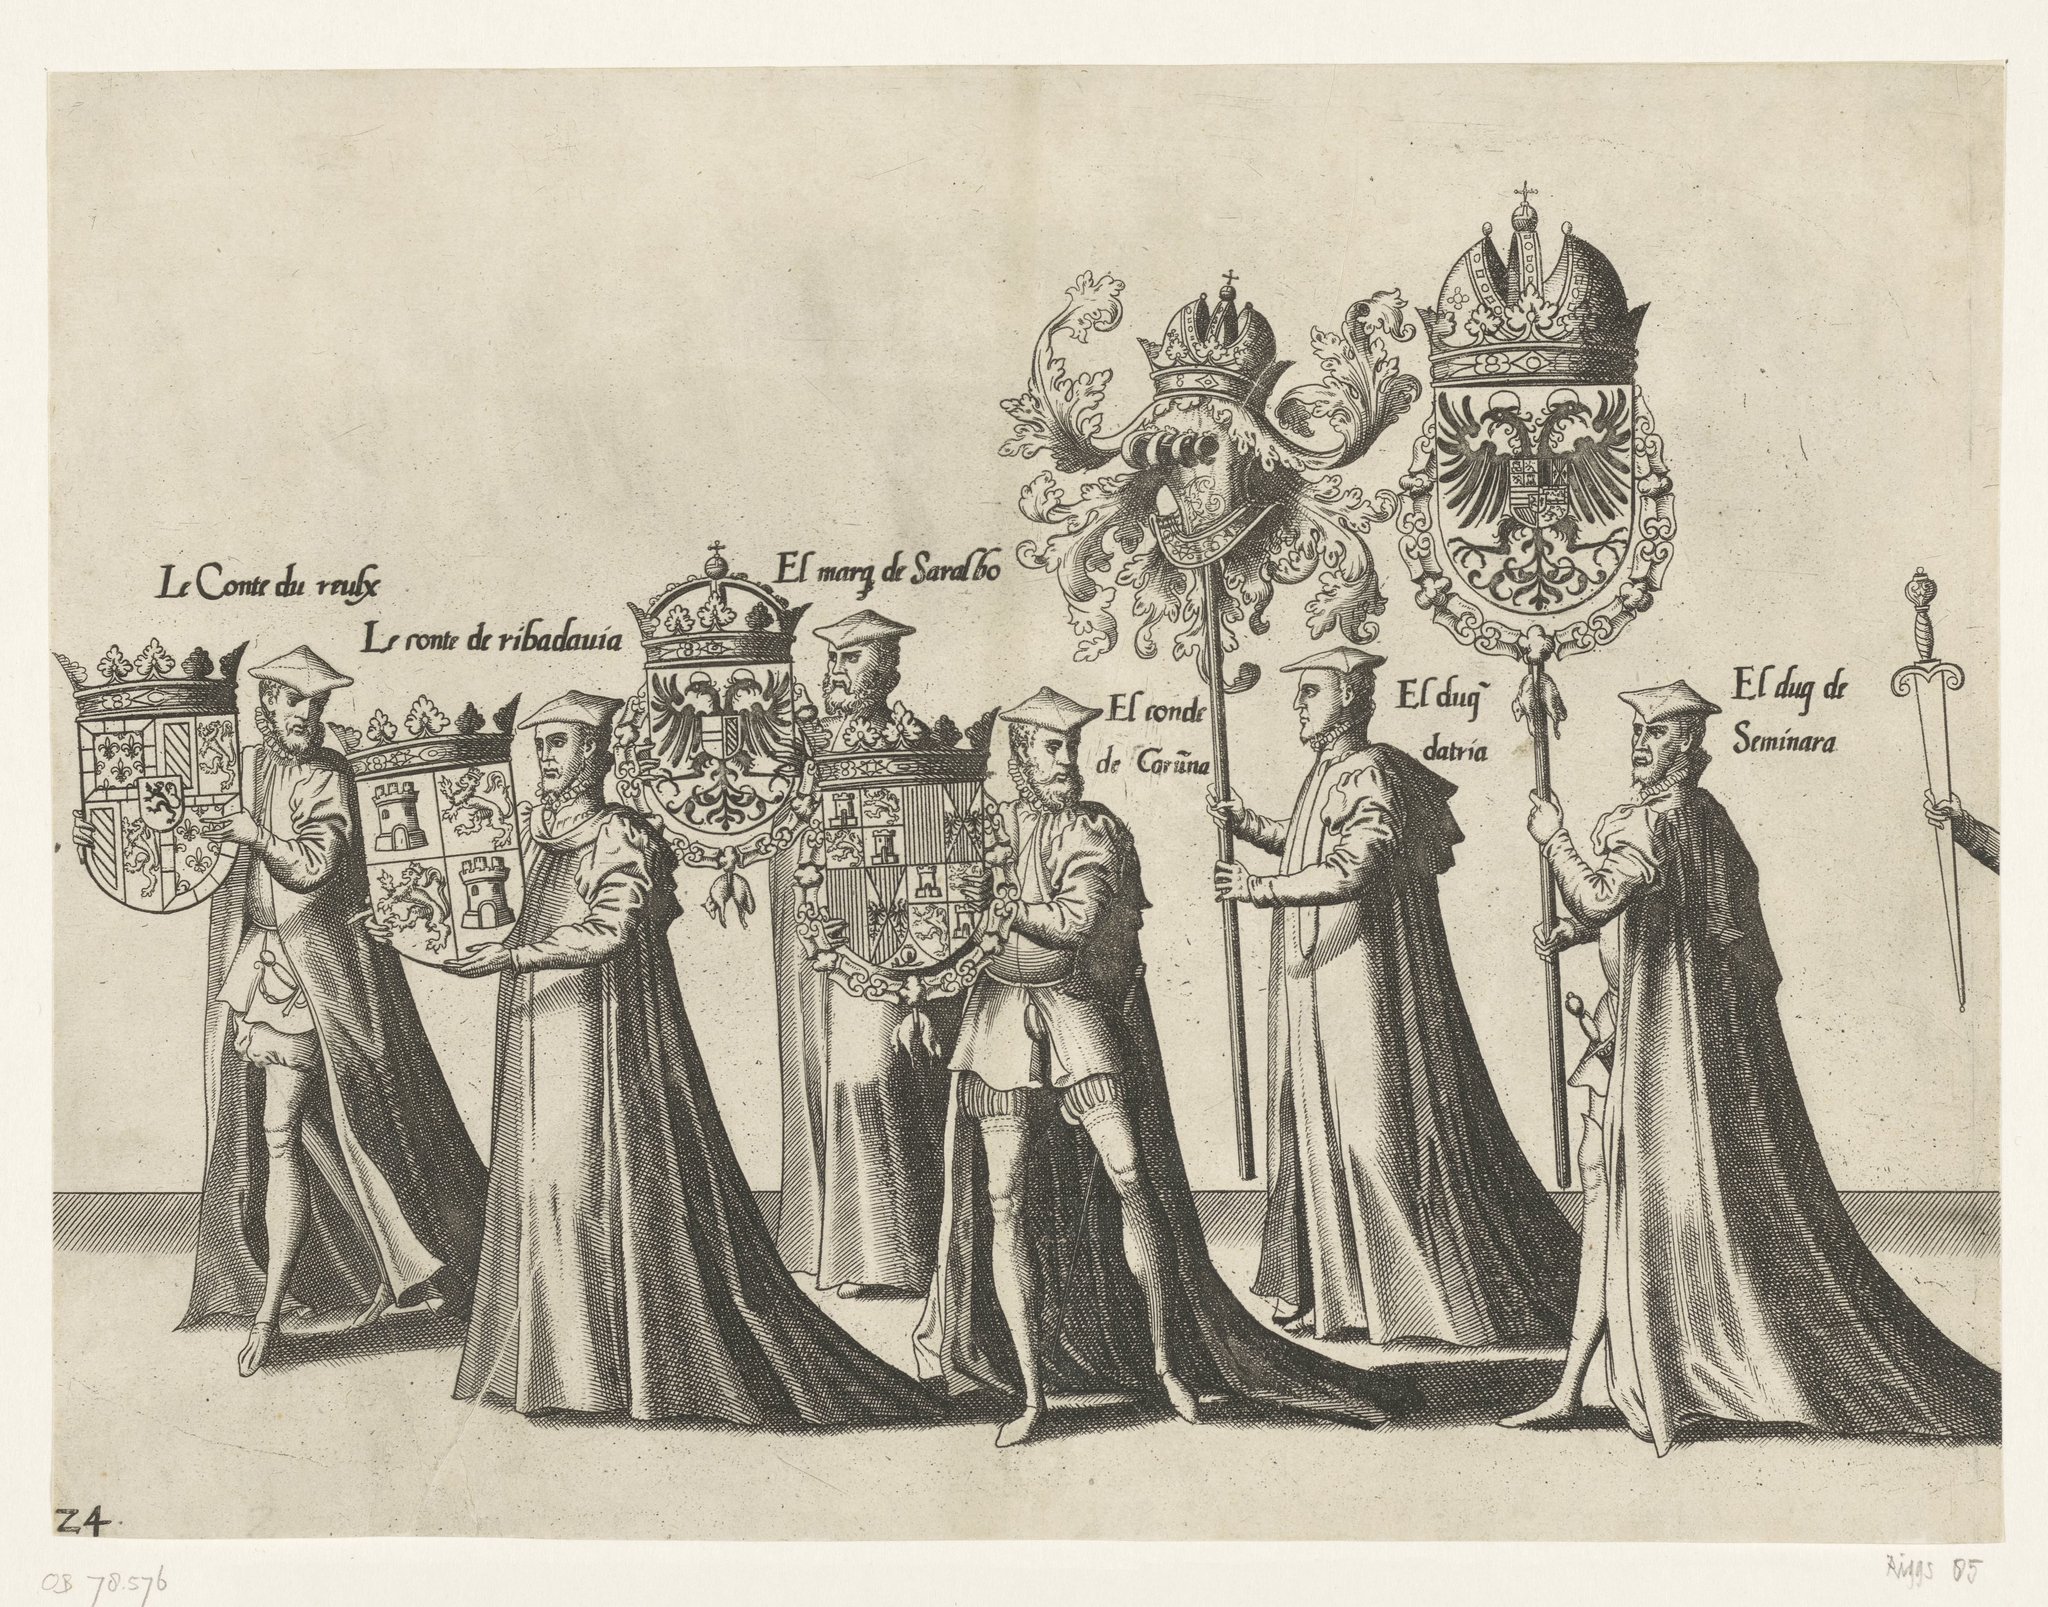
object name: print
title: Begrafenisoptocht van keizer Karel V, 1558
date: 1559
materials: paper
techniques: engraving, etching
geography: southern netherlands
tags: charles v (holy roman emperor and king of spain), cortege, funeral procession, brussels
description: Zes deelnemers aan de optocht, met de vier kwartieren van het keizerlijk wapen en het keizerlijk wapen en helm op standaarden. Onderdeel van de prentreeks van de Begrafenisoptocht van keizer Karel V op 29 december 1558 te Brussel.